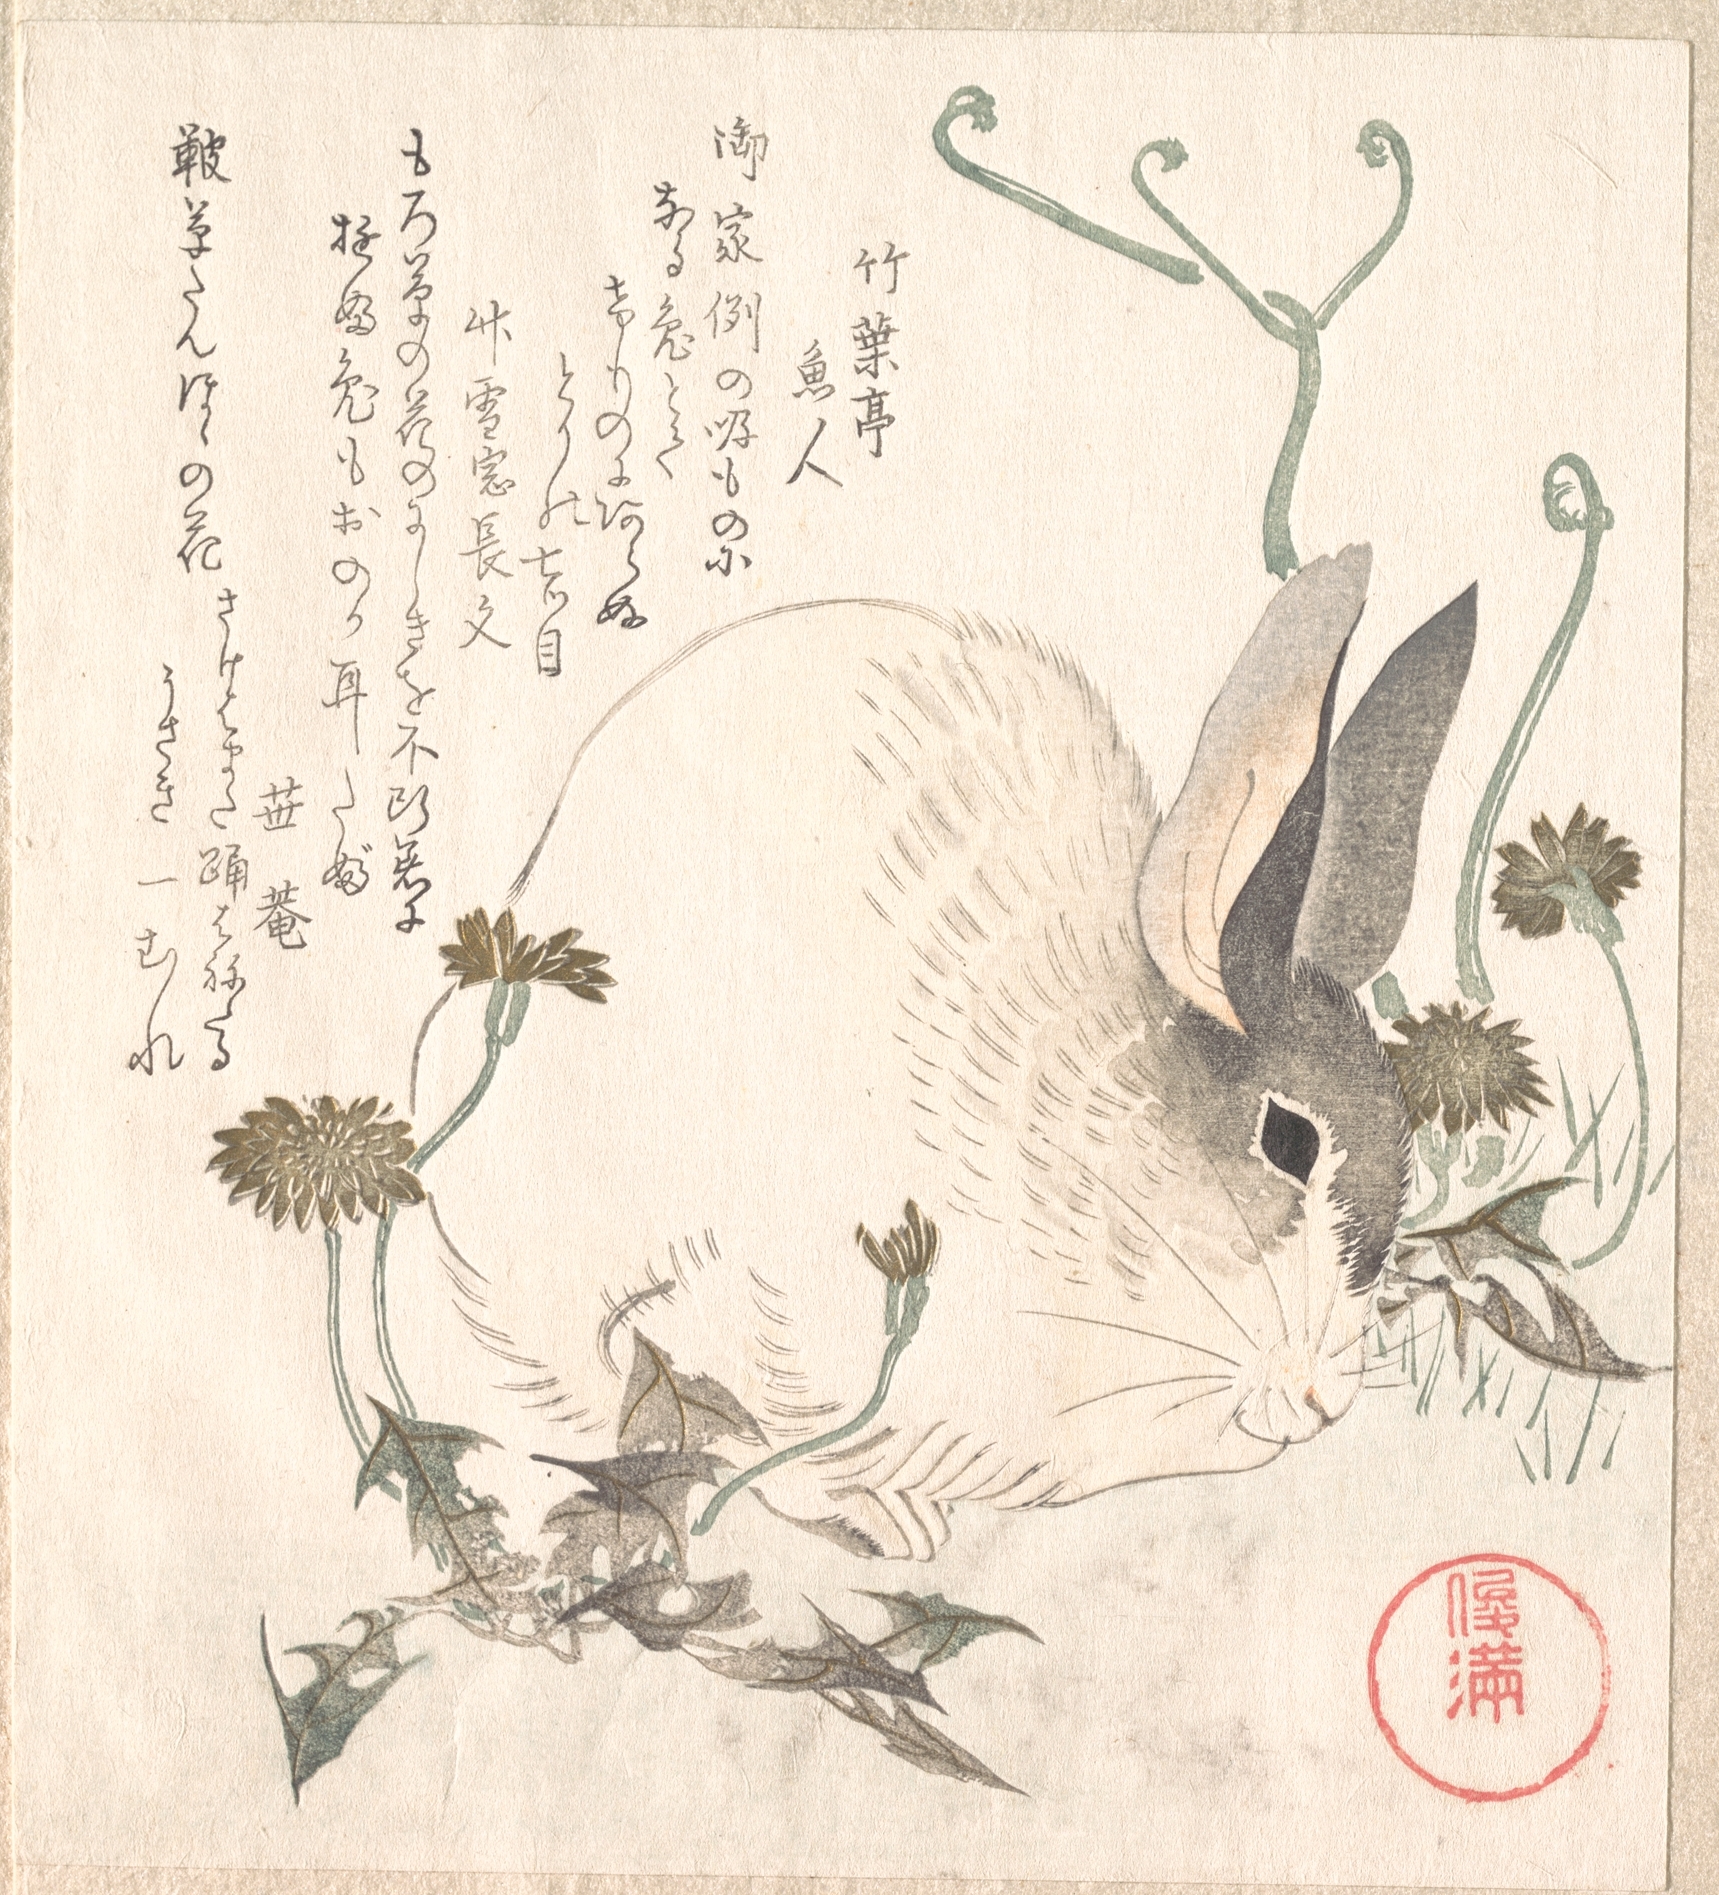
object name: print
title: Hare and Dandelion?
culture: japanese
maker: kubo shunman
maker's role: artist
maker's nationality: japanese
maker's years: 1757-1820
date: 1820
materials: ink, paper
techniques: surimono, woodblock print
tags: rabbits